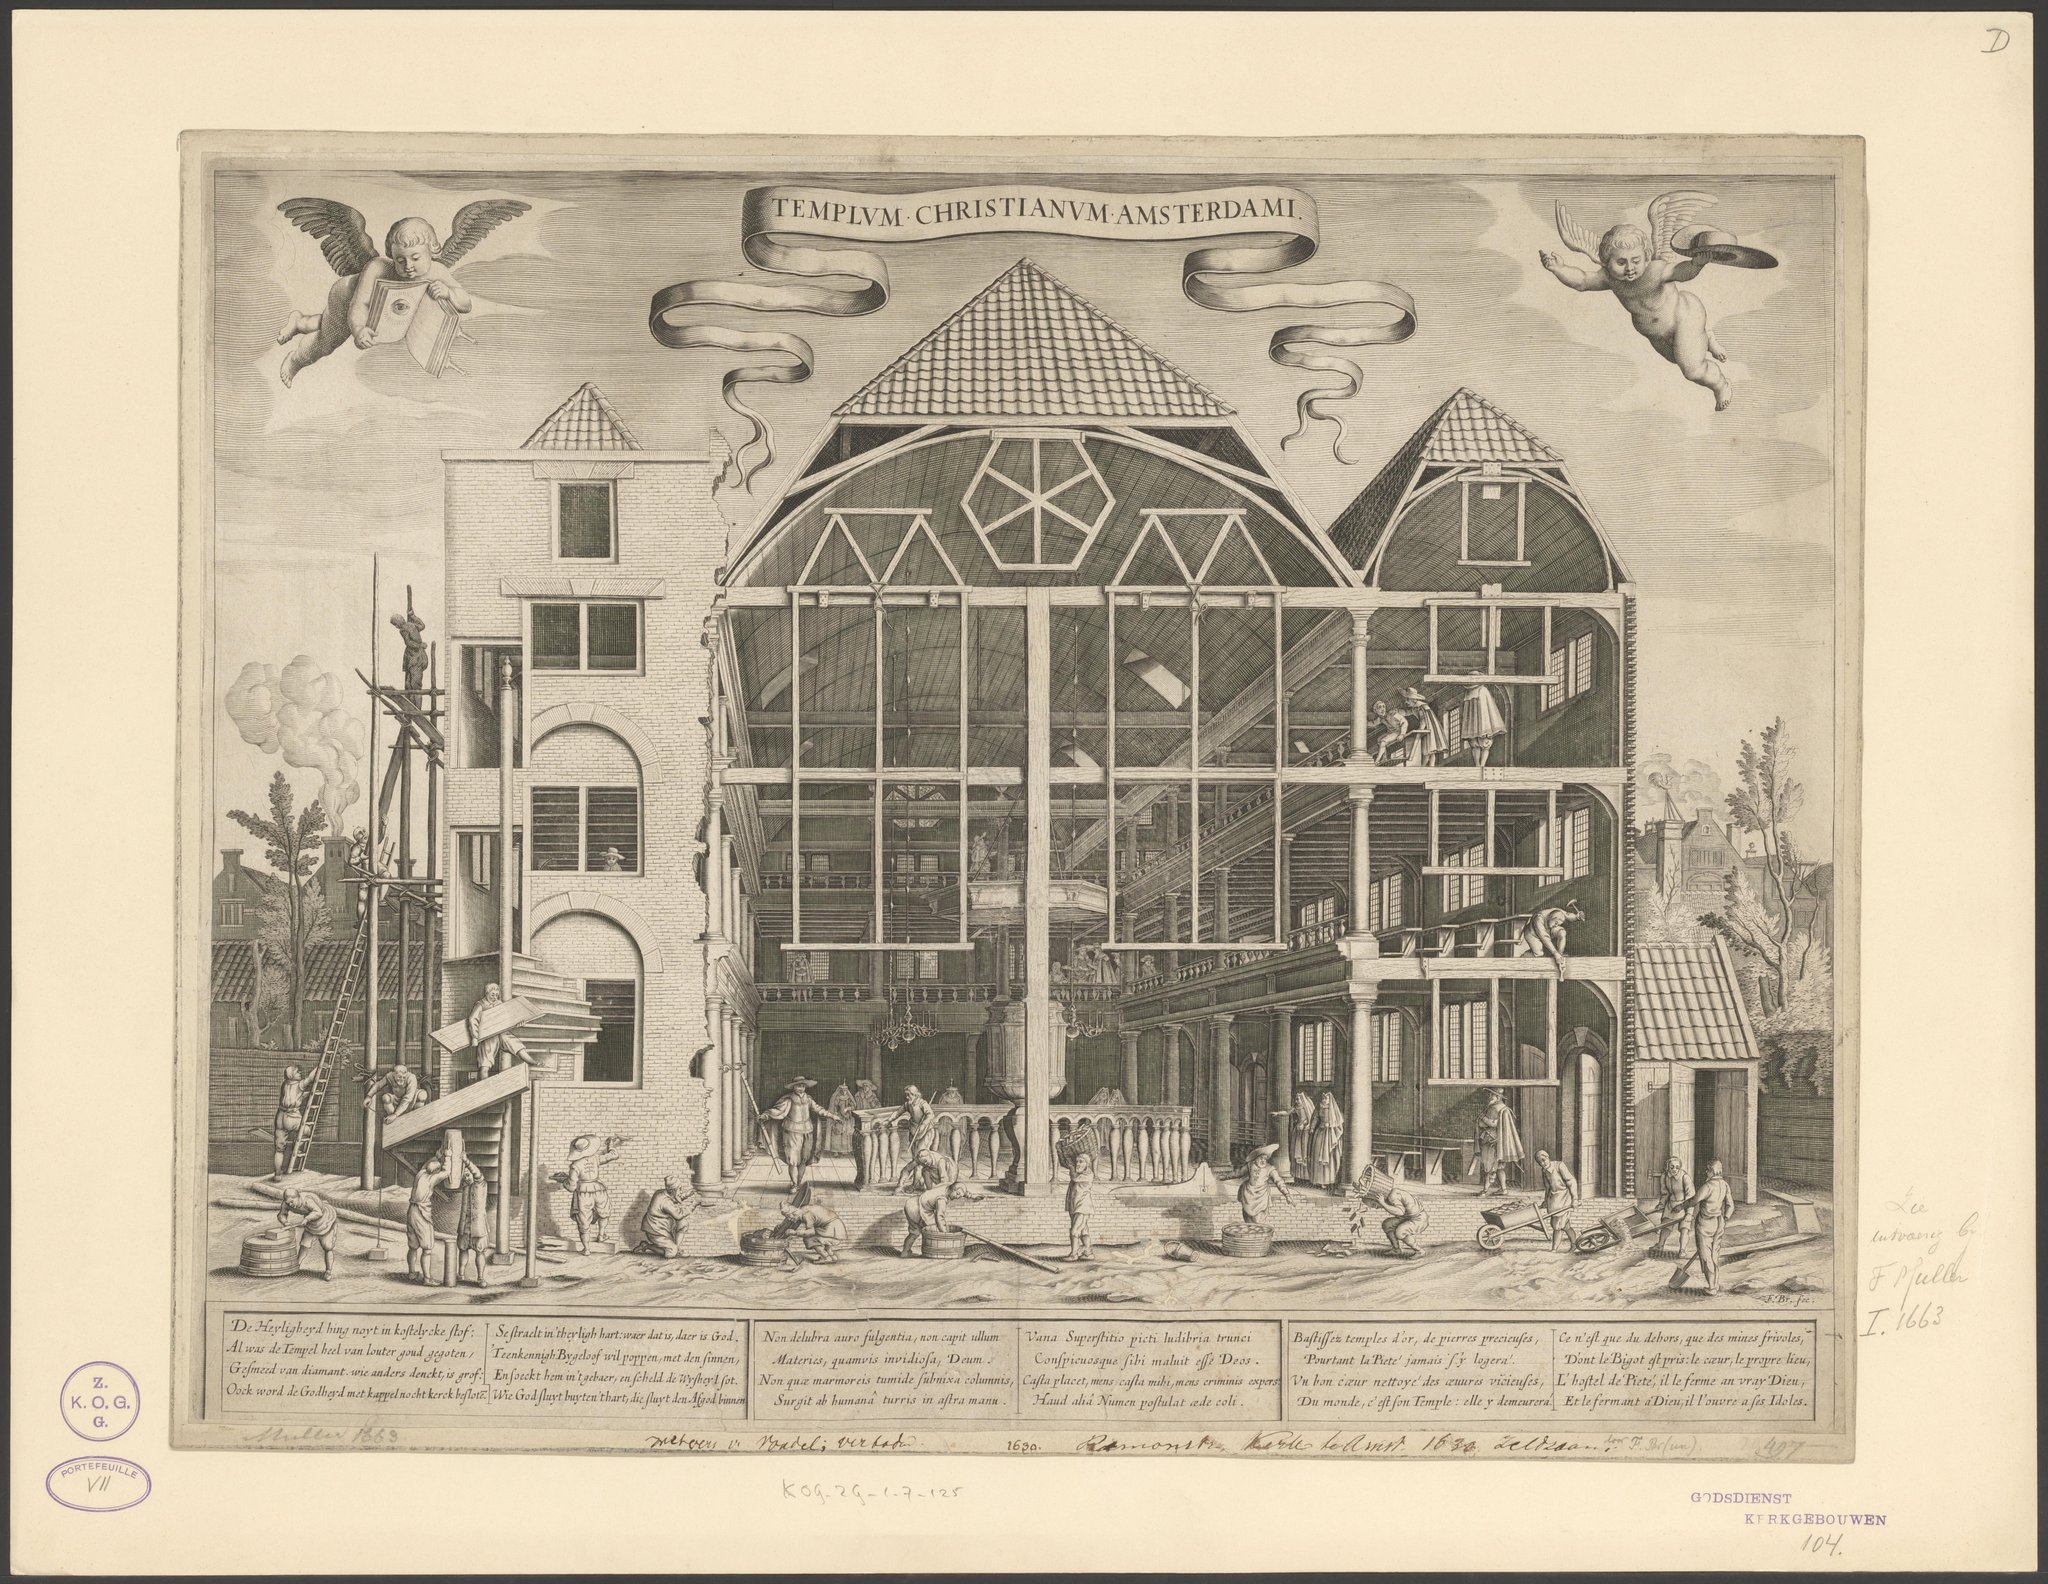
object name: print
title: Templum Christianum Amsterdami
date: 1630-1632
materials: paper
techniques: engraving, etching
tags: protestant churches and denominations, church (exterior), interior of church, building of church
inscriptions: collector's mark: Lugt 1641, stamp, stamp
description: De Remonstrantse of Arminiaanse Kerk aan de Keizersgracht te Amsterdam in aanbouw. De kerk werd op 8 september 1630 ingewijd. De bouwwerkzaamheden aan de binnen- en buitenkant zijn in volle gang. Linksboven een putto met een bijbel met het alziend oog. Boven in het midden een banderol met de titel. Rechtsboven een putto met de vrijheidshoed. Onder de voorstelling drie verzen dan elk acht regels over twee kolommen in het Nederlands, Latijn en Frans. De Nederlandse versie is geschreven door Vondel. De Latijnse en Franse verzen zijn daar vertalingen van. Onderwerpsrubrieken binnen de Atlas Zeden en Gewoonten: Godsdienst, Kerkgebouwen te Amsterdam.